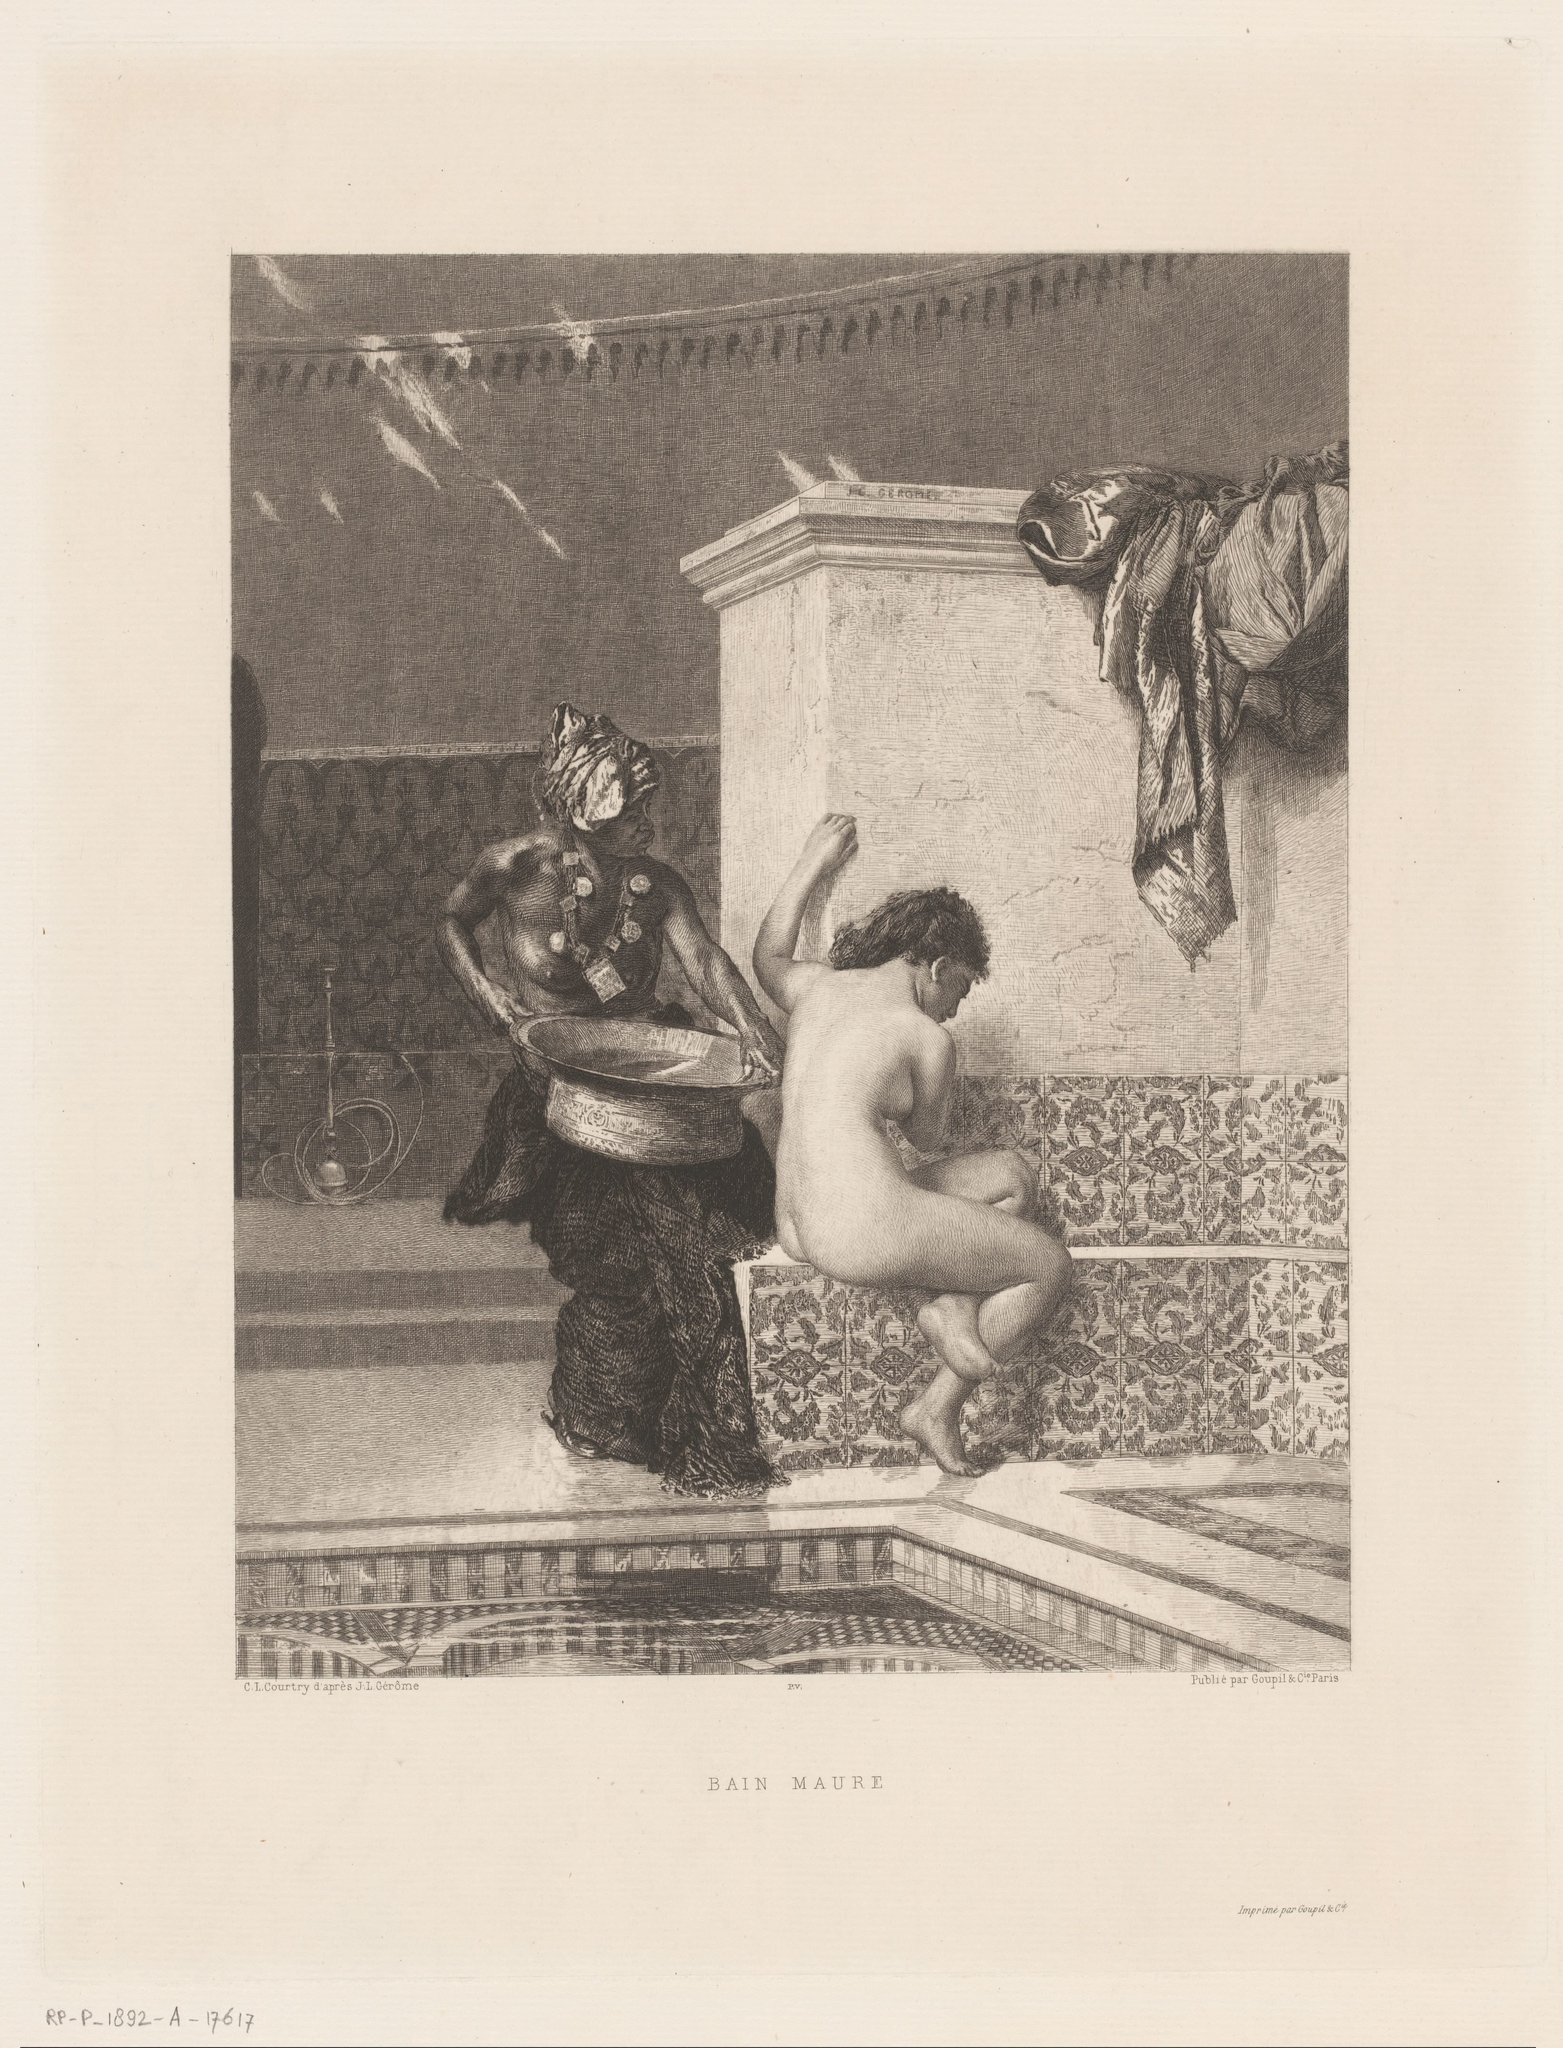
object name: print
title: Bain maure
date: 1873-1874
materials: paper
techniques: drypoint, etching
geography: paris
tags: public baths (+ two together)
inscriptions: collector's mark: Lugt 2228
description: Twee vrouwen in een Noord-Afrikaans badhuis. Een naakte witte vrouw zit rechts gewend op een stenen bank, de linkerarm naar boven tegen den wand uitgestrekt. Links een zwarte vrouw, die een bekken met water opheft. In de kroonlijst boven de vrouw: I.L. Gérôme. Onder den l.o: C.L. Courtry d'après I.L. Gérôme. Onder den r.o: Publié par Goupil & Cie. Paris. Onderschrift in het midden der marge: Bain maure